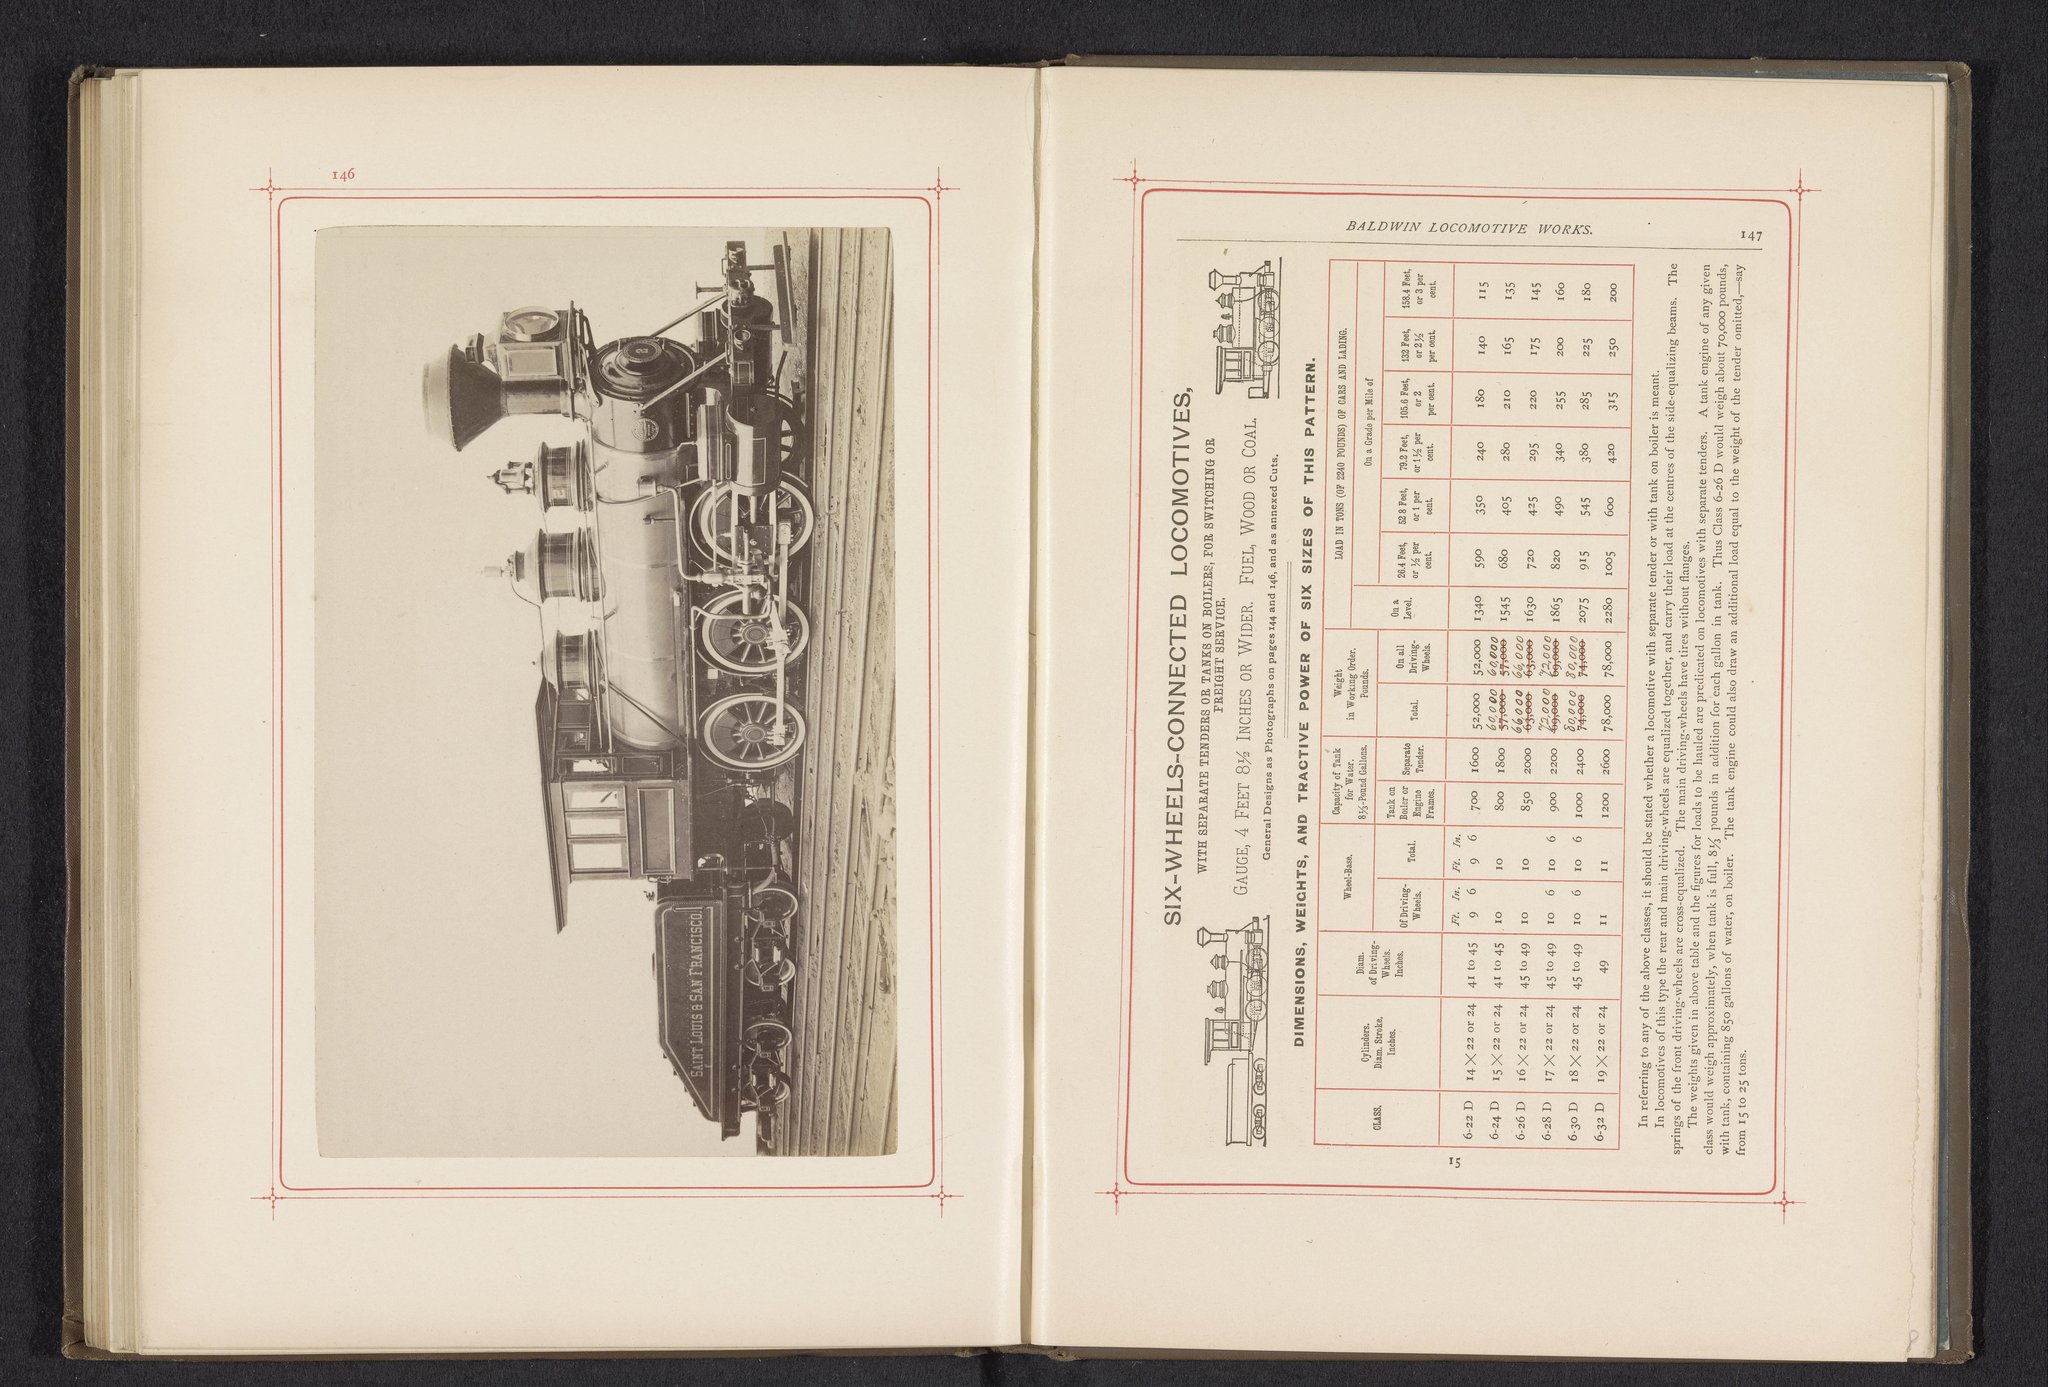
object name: page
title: Amerikaanse stoomlocomotief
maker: Anonymous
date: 1871-1881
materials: photographic support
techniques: albumen print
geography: united states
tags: steam locomotive